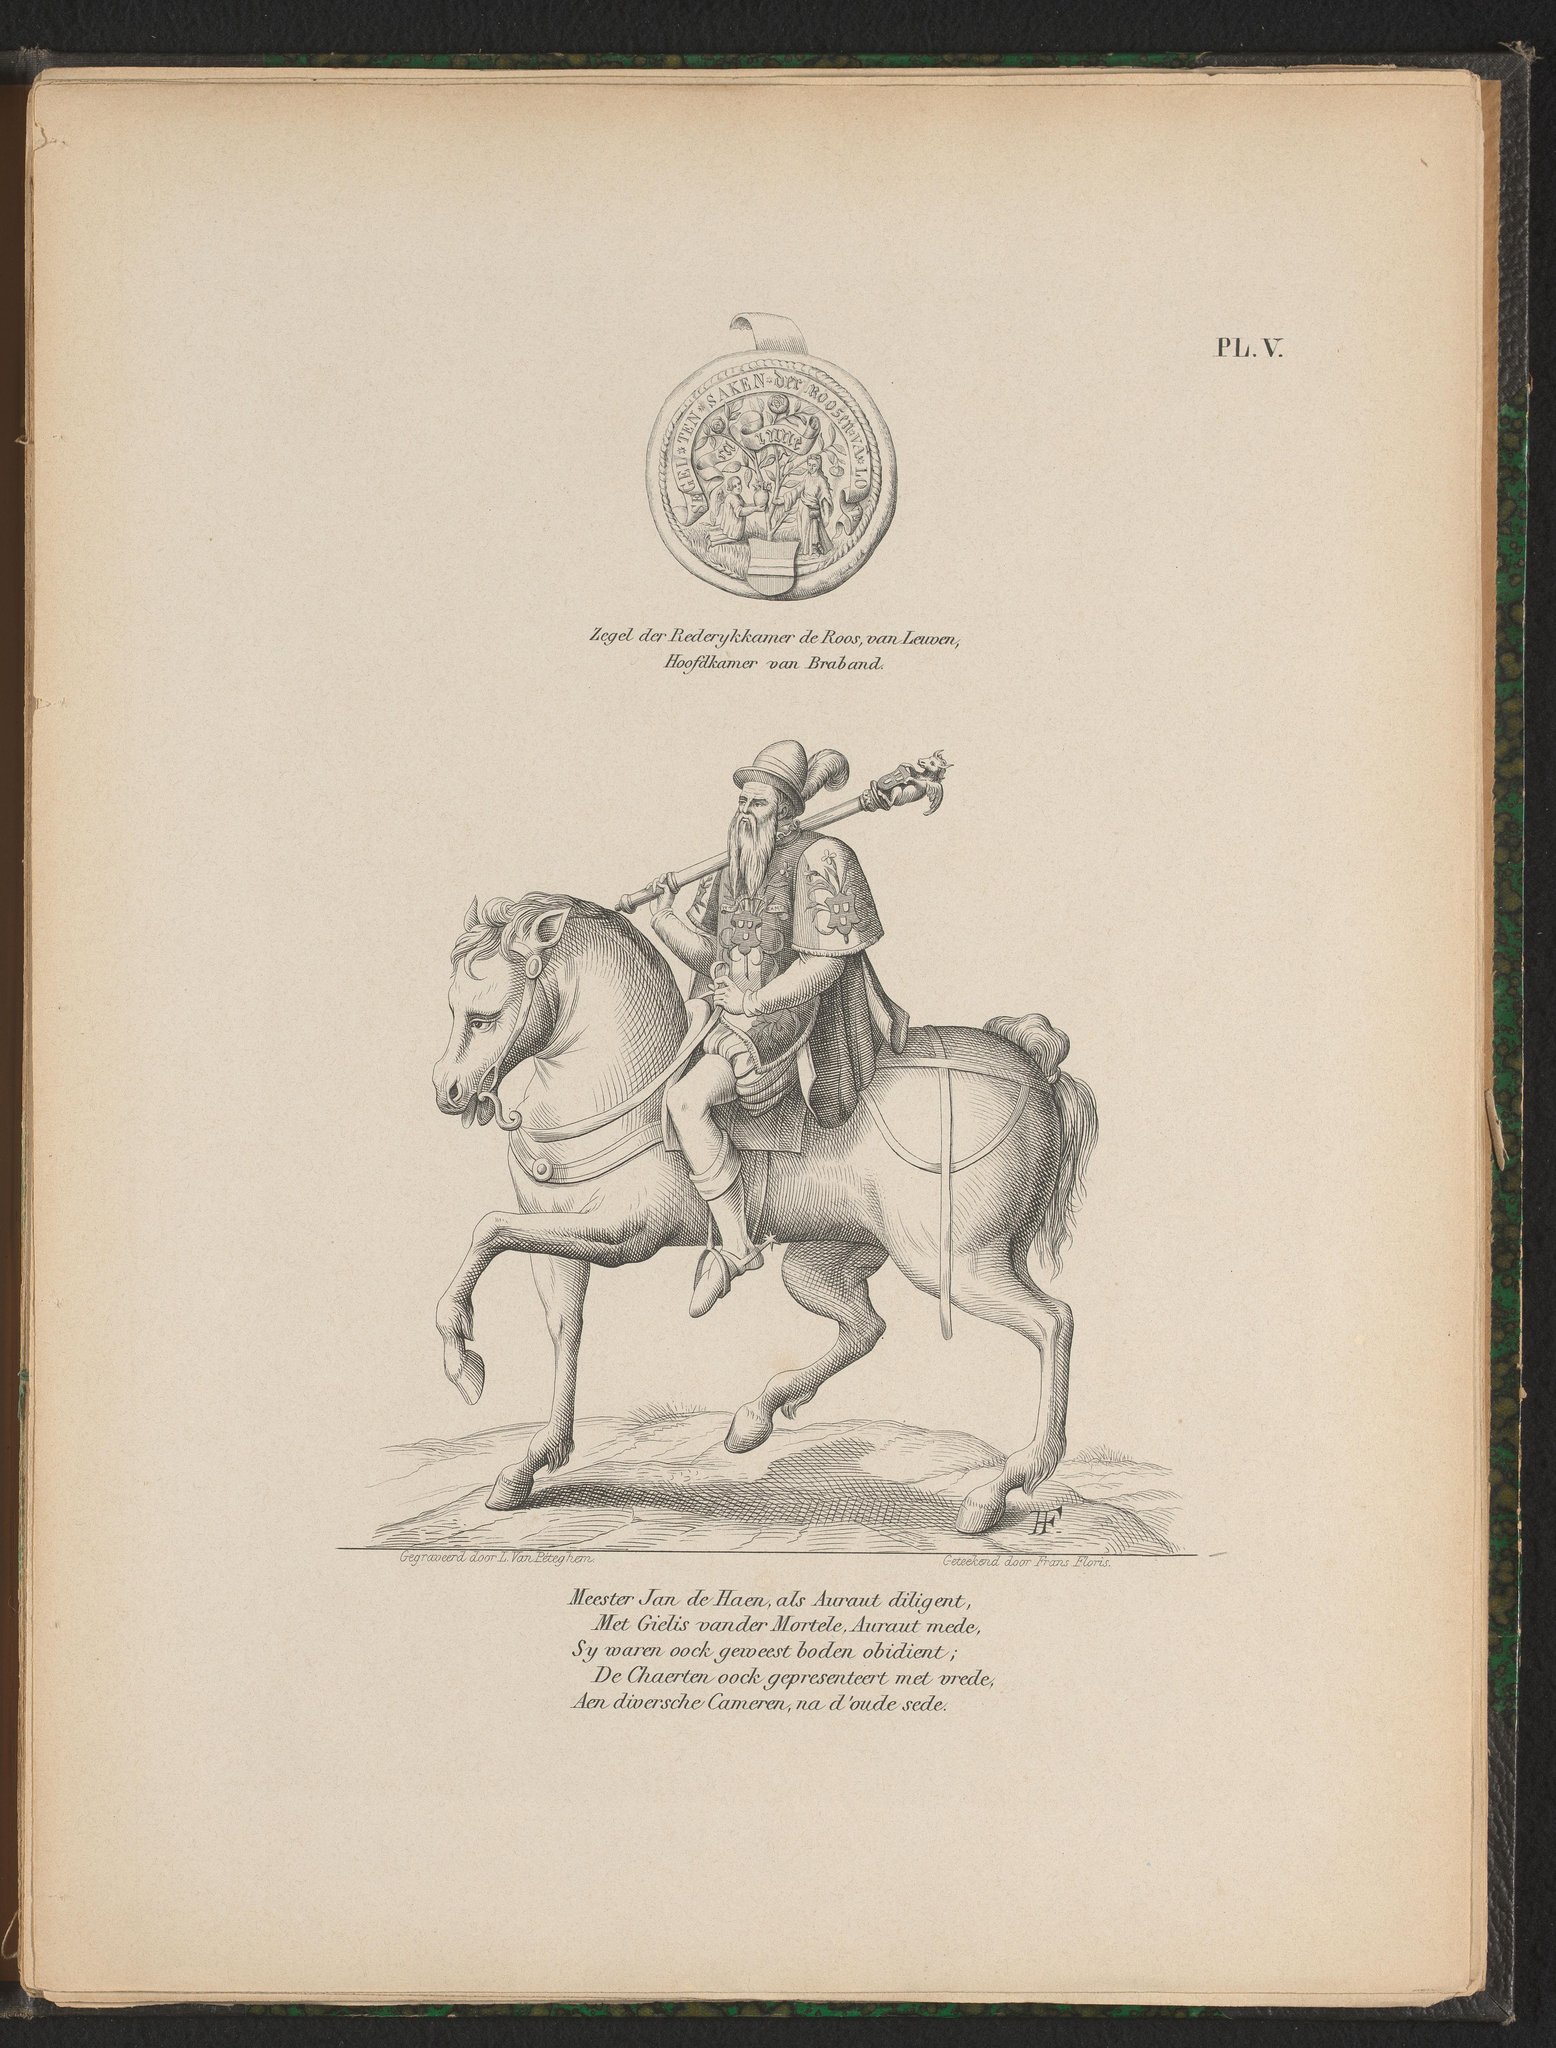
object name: print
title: Meester Jan de Haen, heraut van De Violieren, te paard, 1561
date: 1859-1861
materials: paper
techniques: lithograph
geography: belgium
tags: chamber of rhetoric (dutch: 'rederijkerskamer'), antwerp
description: Meester Jan de Haen, heraut van De Violieren, te paard, 1561. Boven het zegel van de rederijkerskamer De Roos te Leuven. Plaat V in een map met 35 genummerde platen, de meeste naar de illustraties in de oorspronkelijke uitgave van het Landjuweel van Antwerpen in 1561.